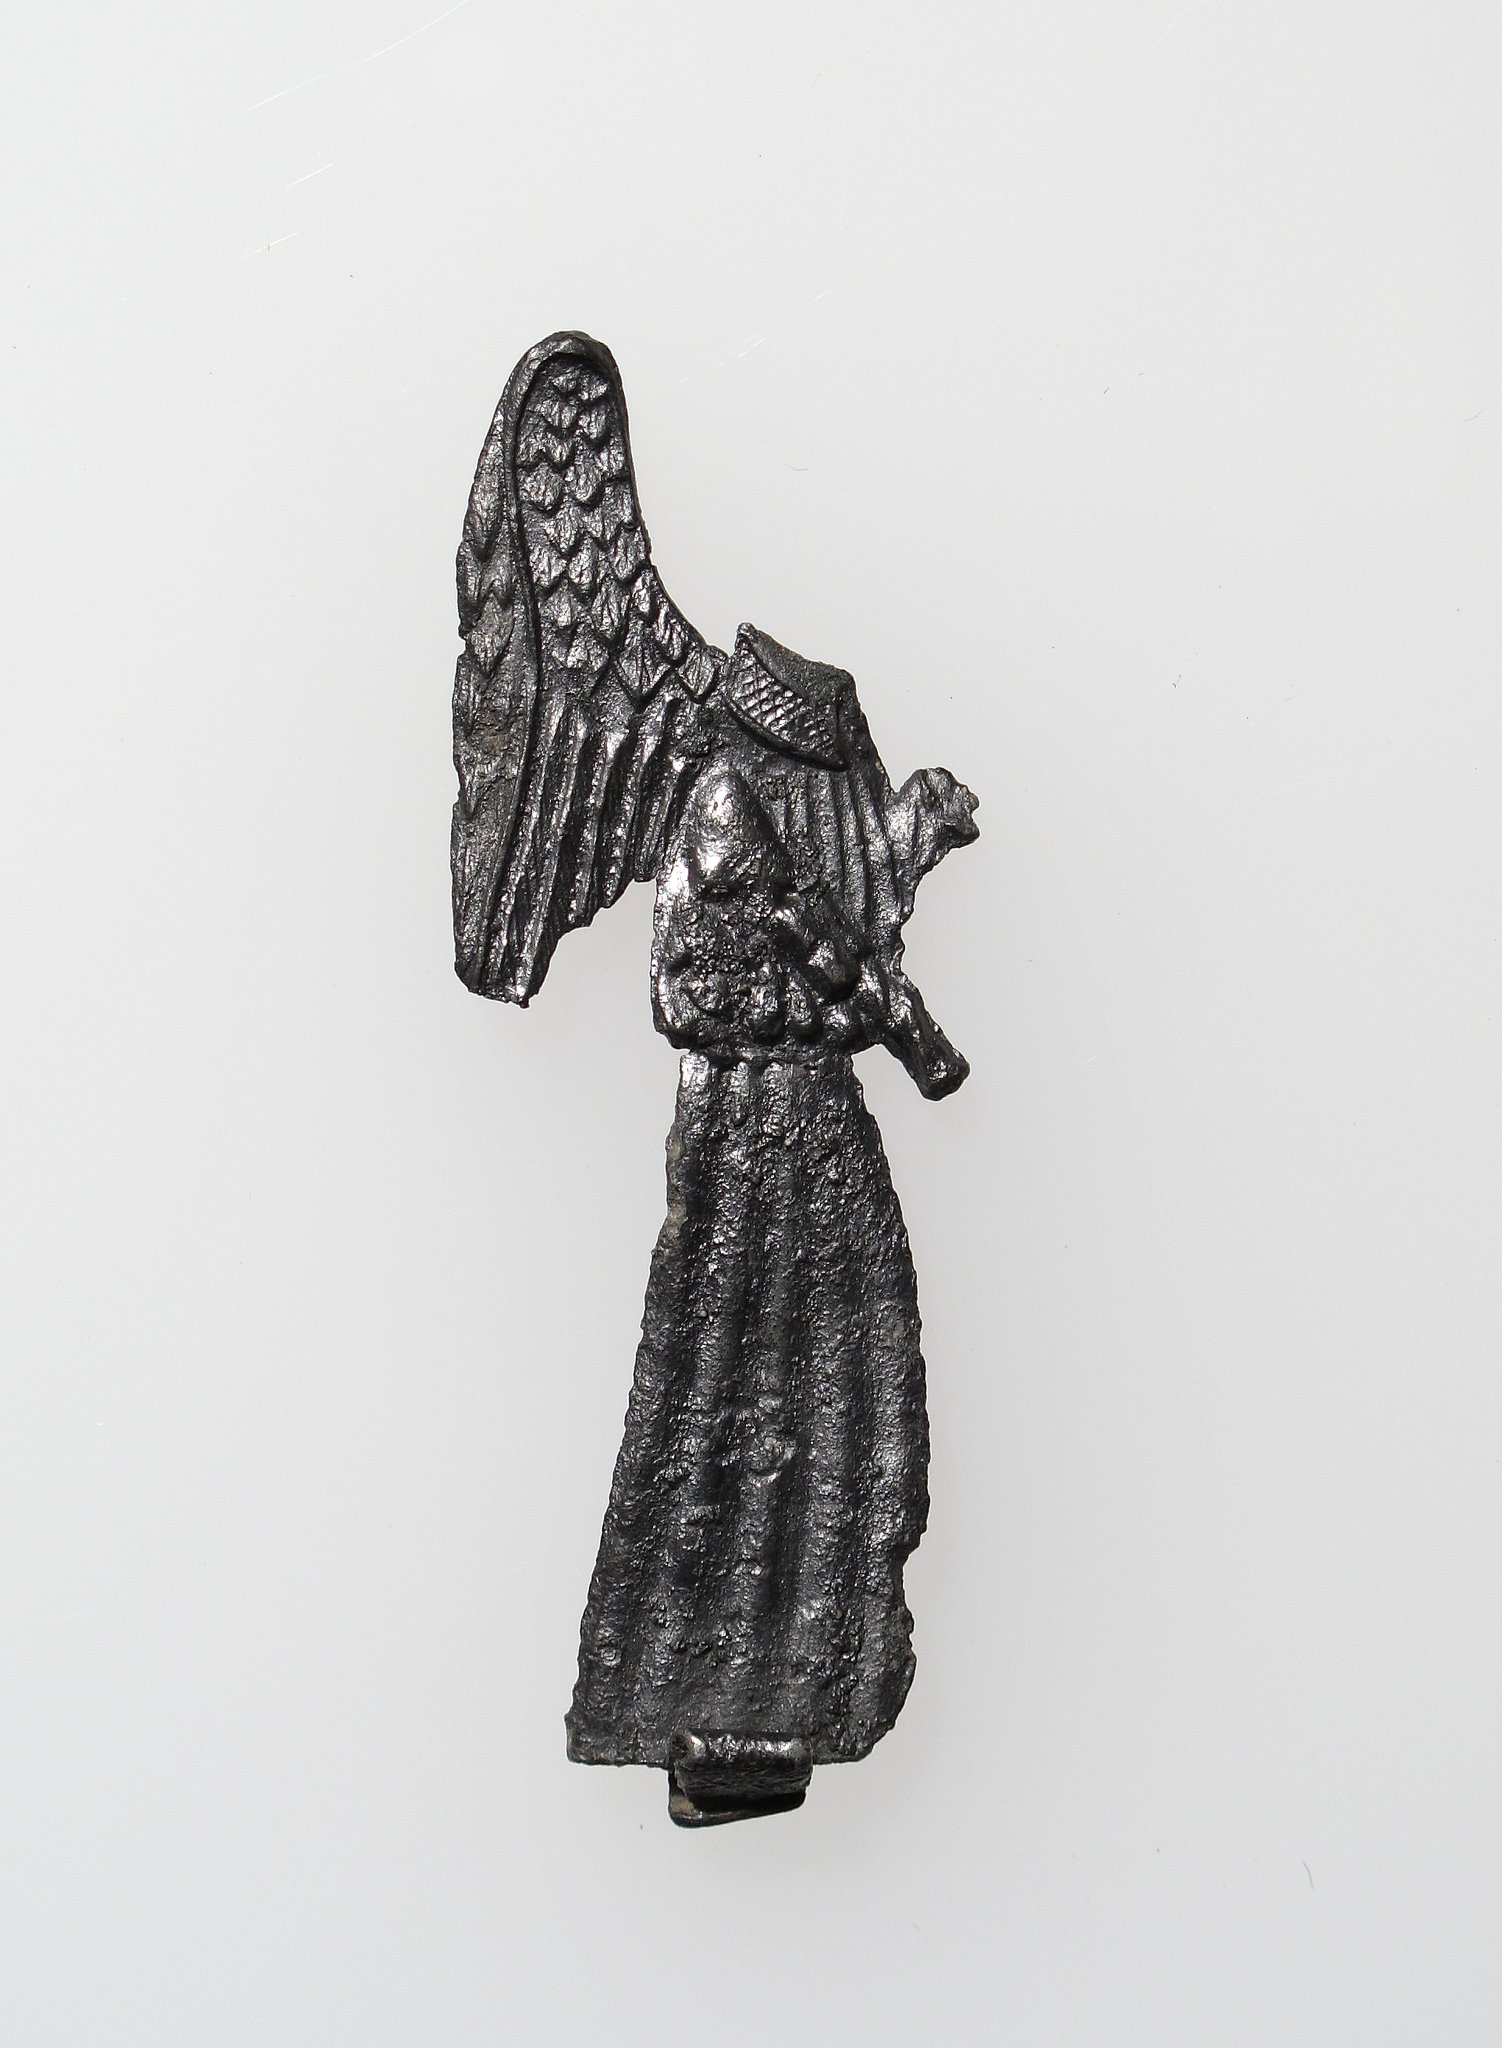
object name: pilgrim's badge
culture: french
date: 1301-1600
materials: lead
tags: angels